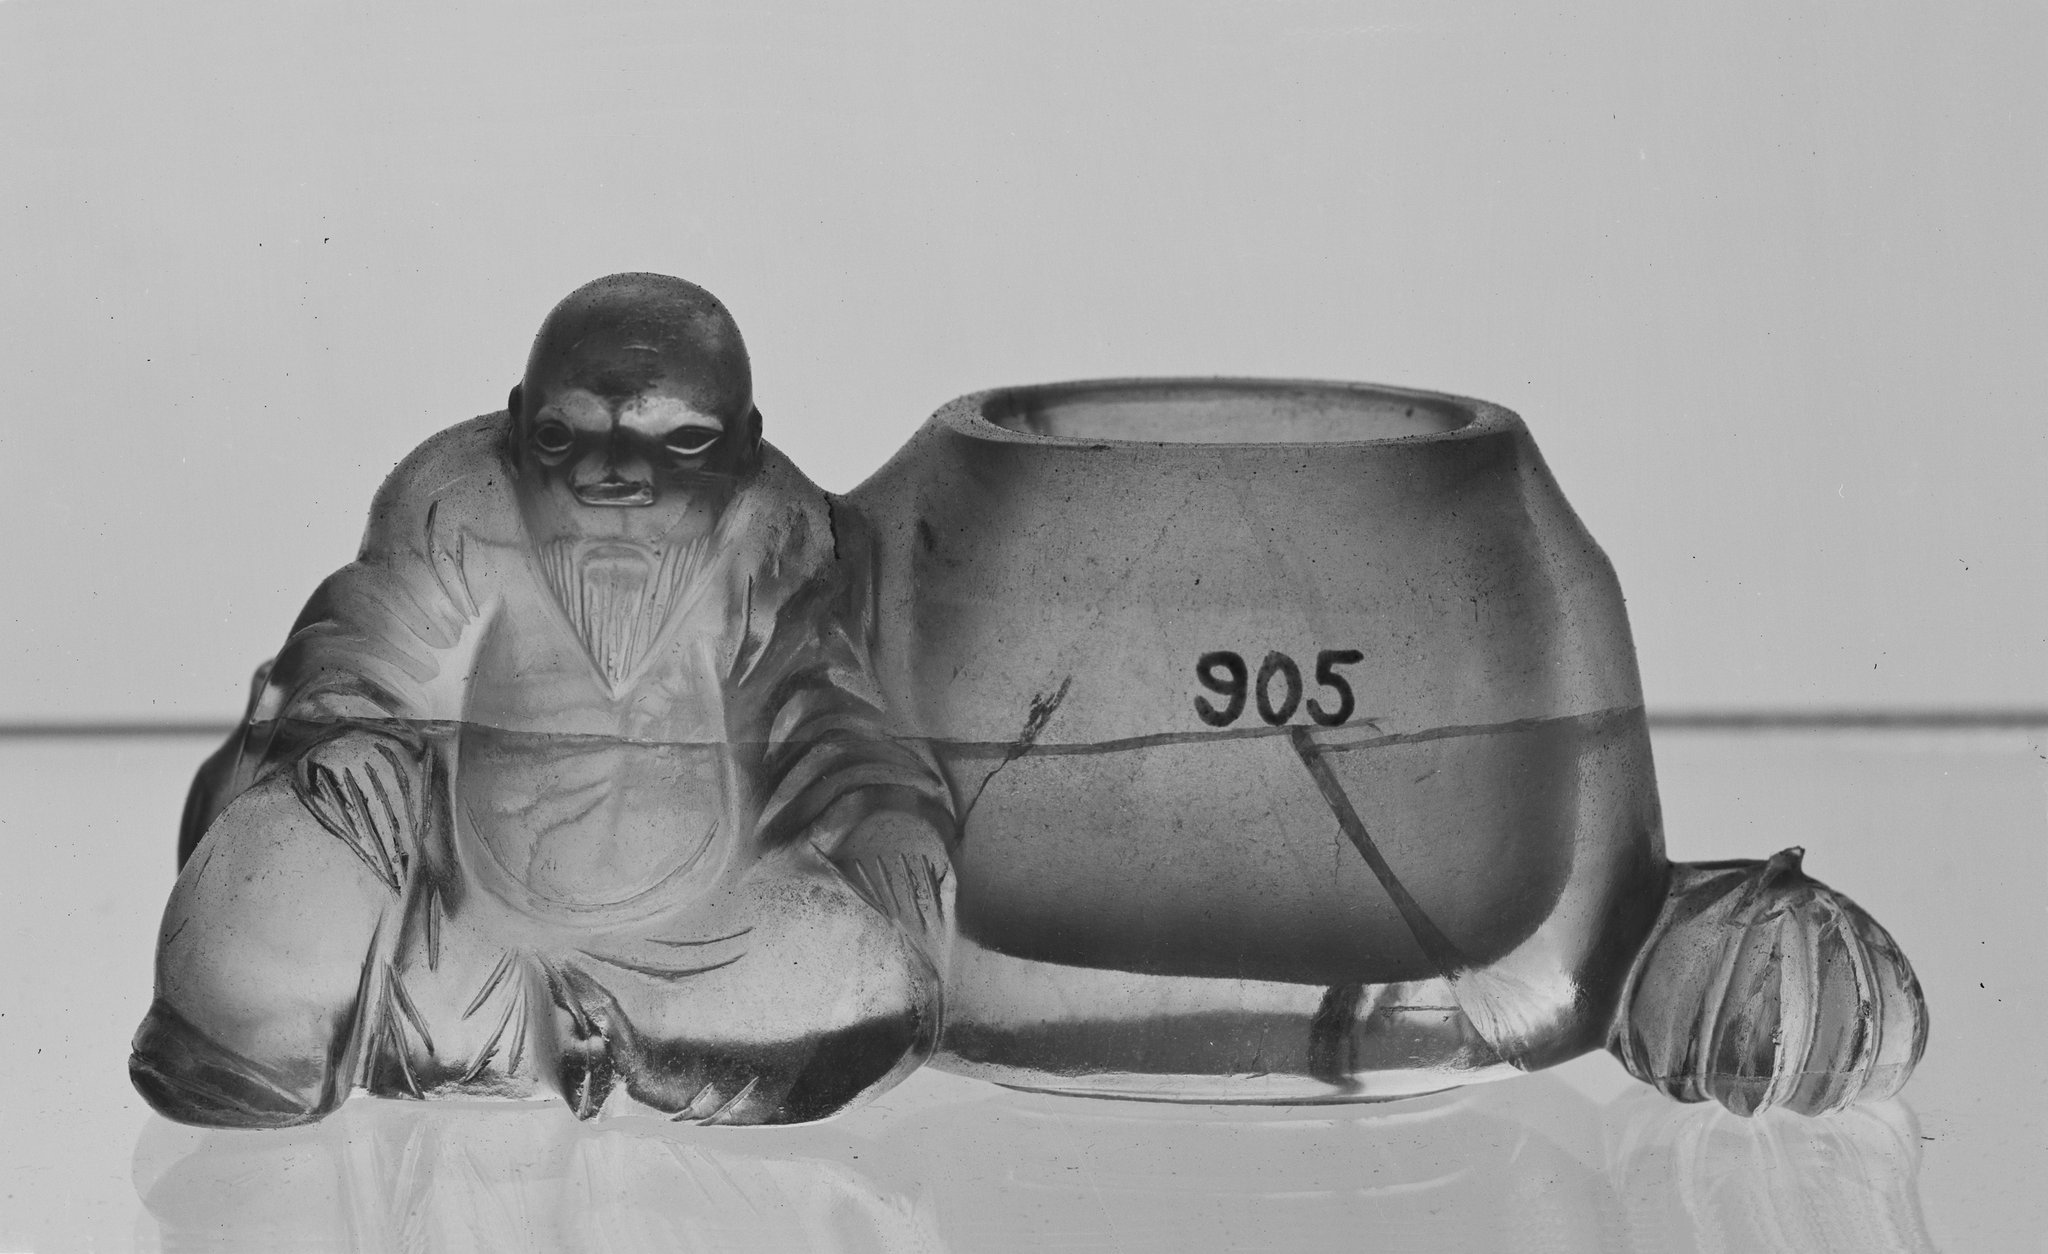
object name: ink stand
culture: chinese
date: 1701-1800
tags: men